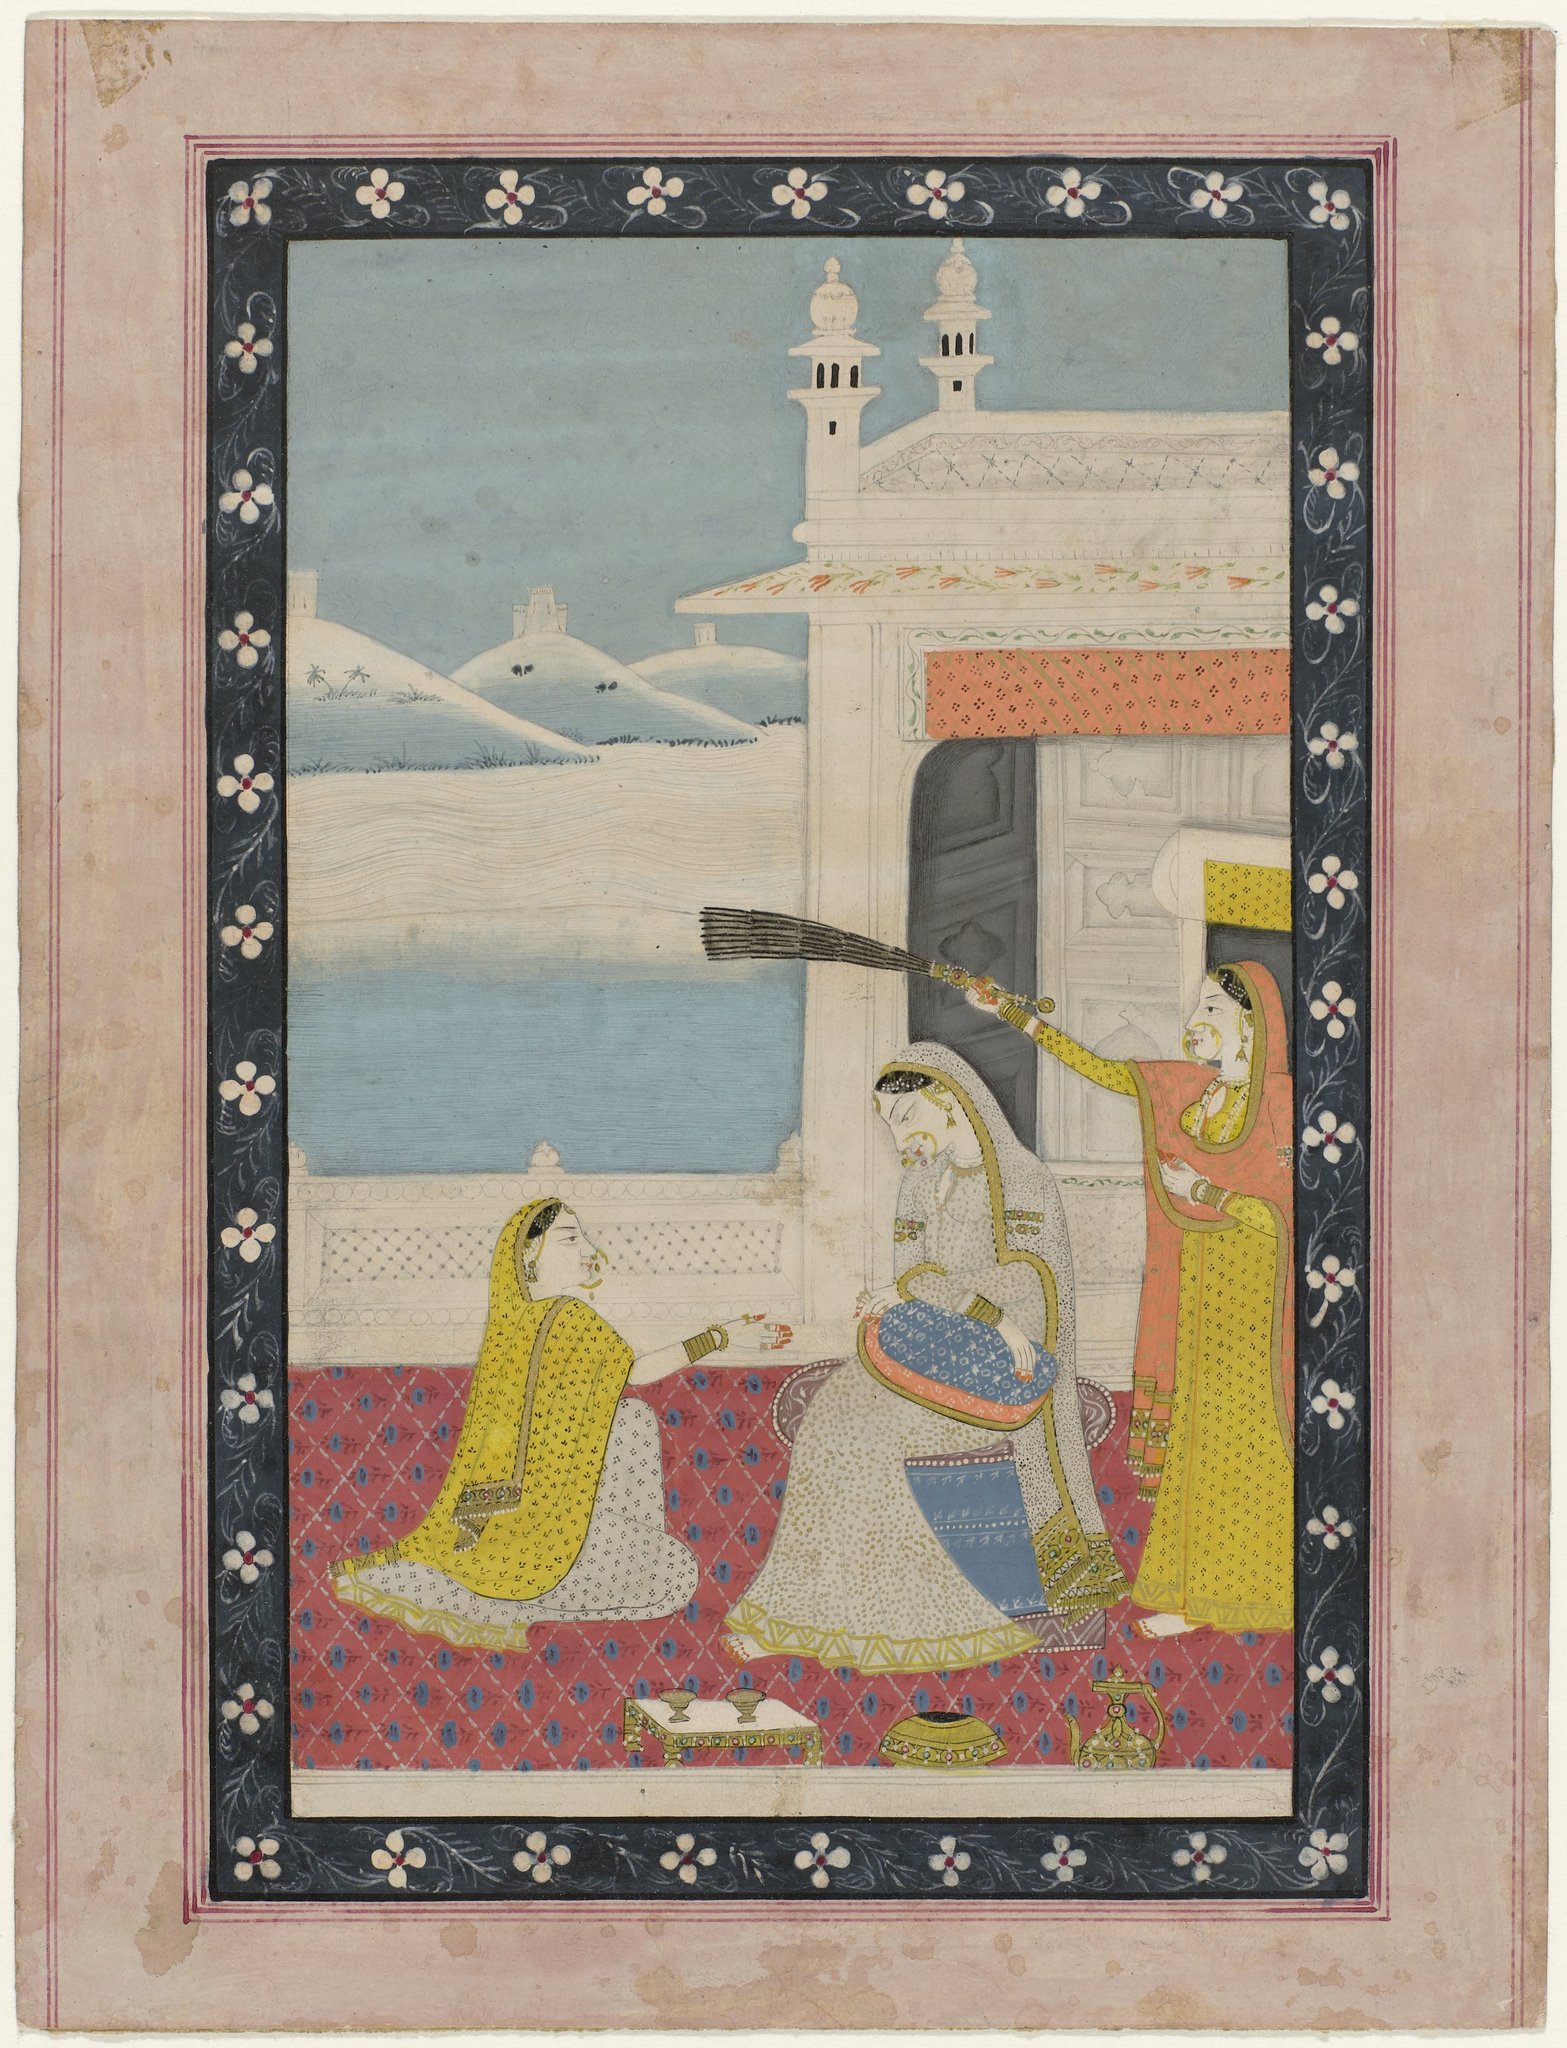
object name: indian miniature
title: Zittende dame op terras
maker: Anonymous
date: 1790-1810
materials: paper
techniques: brush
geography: guler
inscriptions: inscription: ‘.’